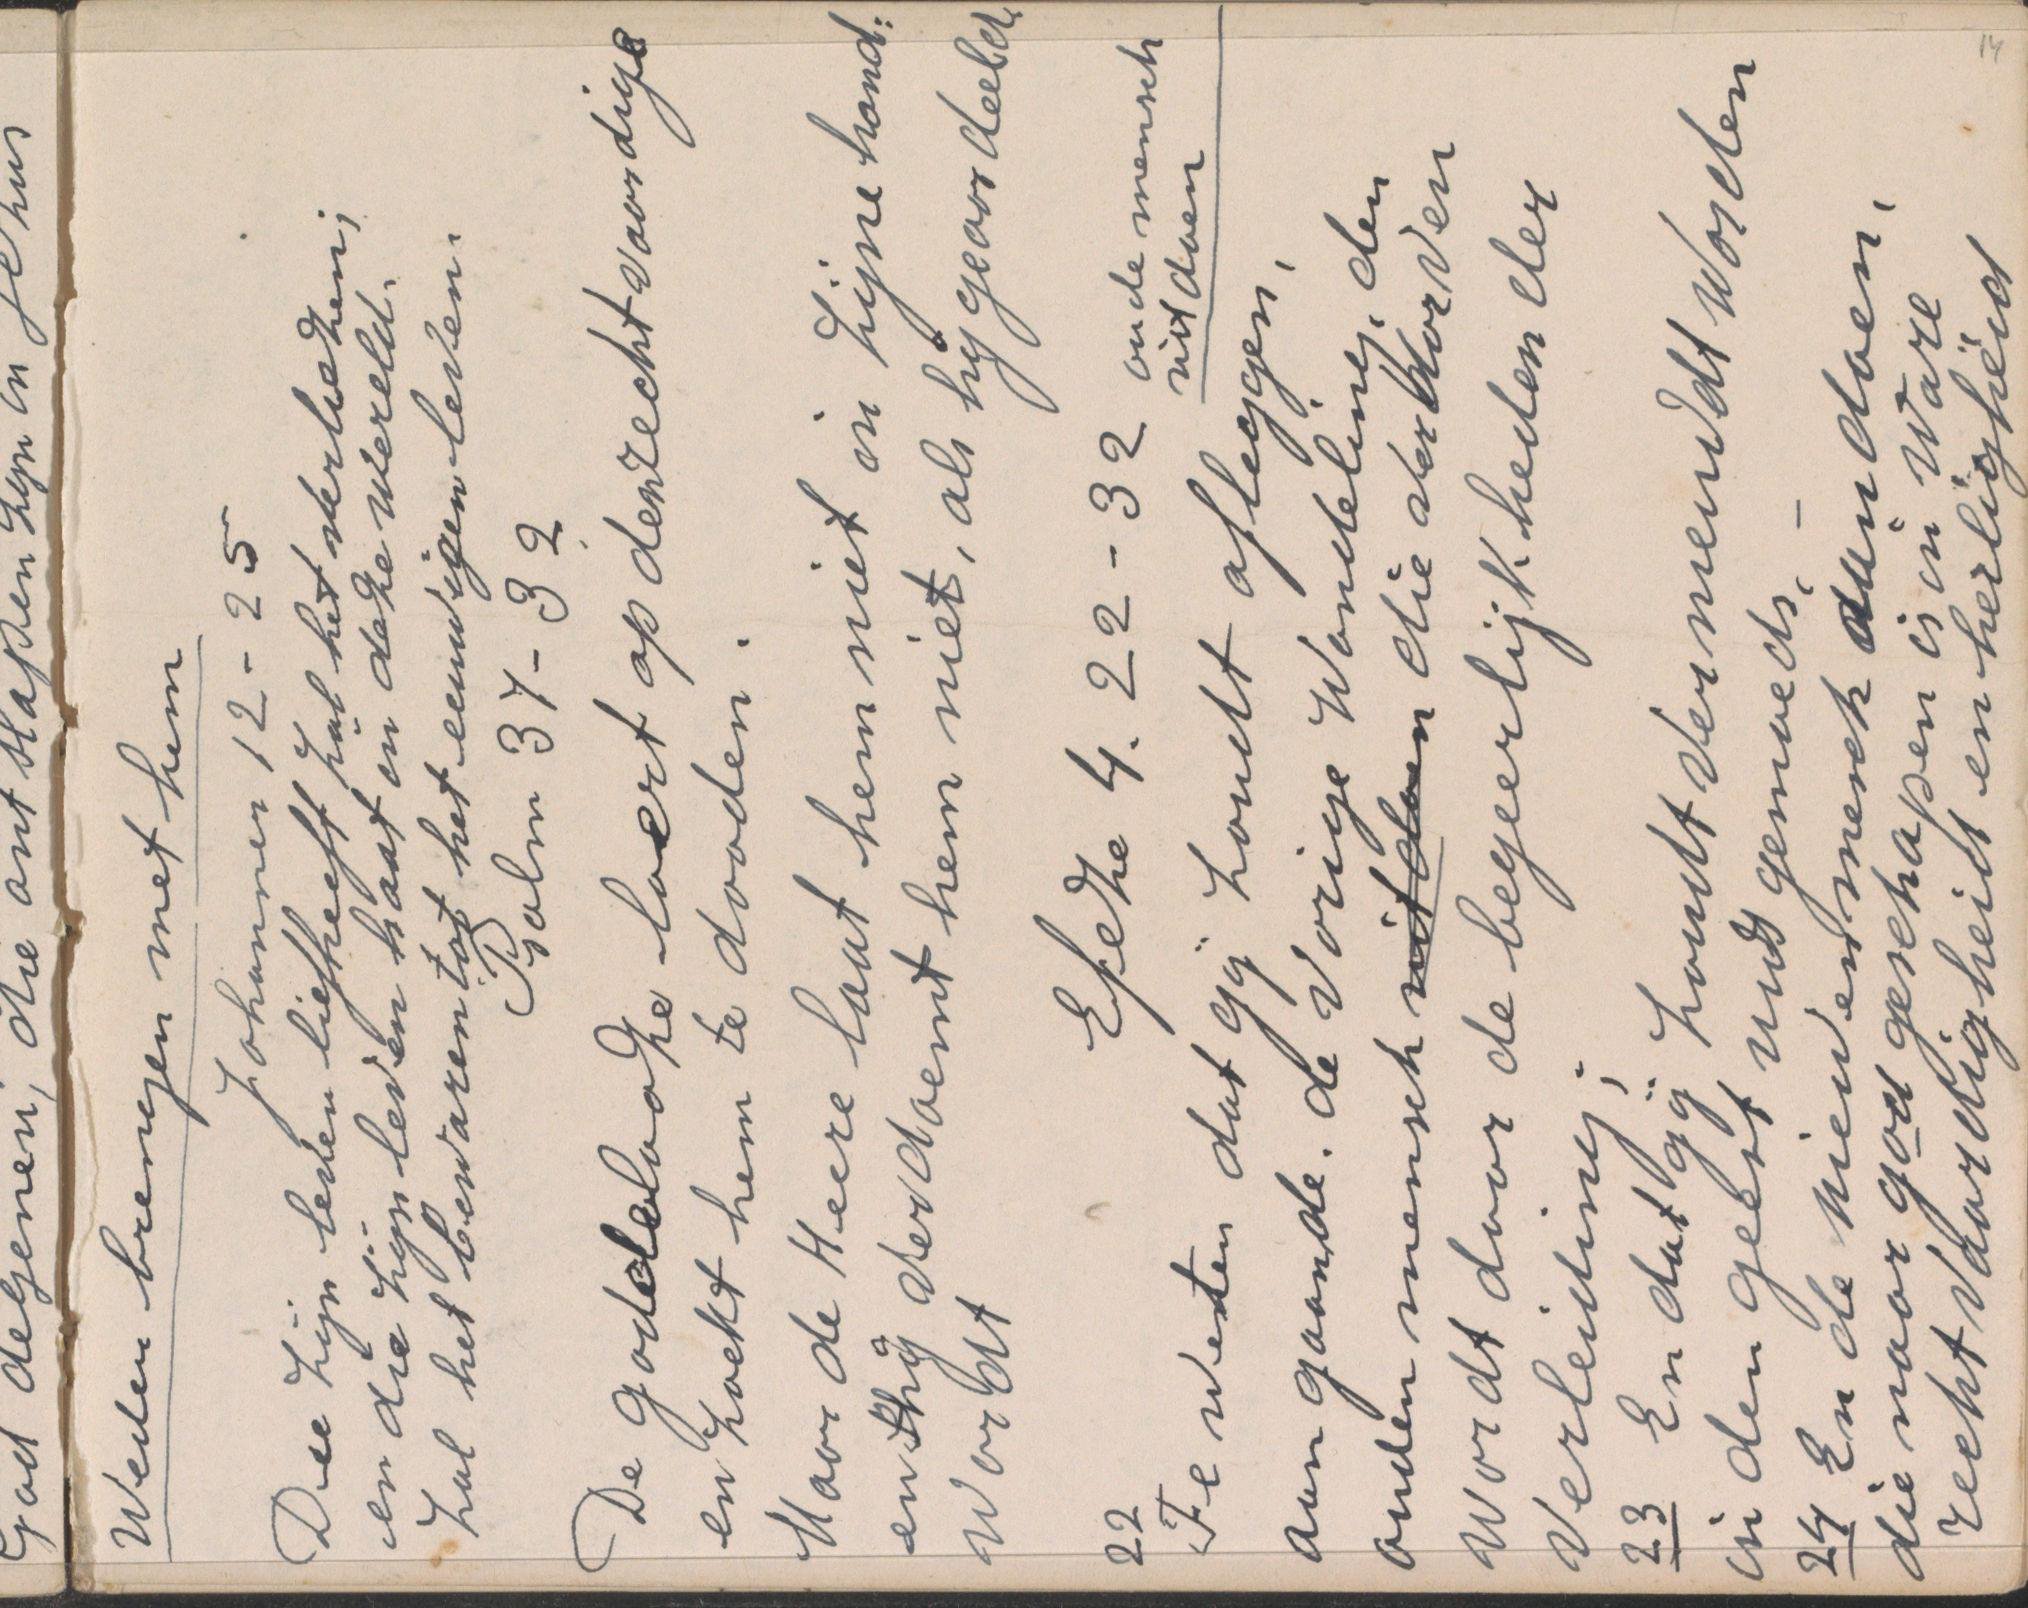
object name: sketchbook leaf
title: Bijbelverzen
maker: marie jordan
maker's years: 1866-1948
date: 1906-1948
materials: ink, paper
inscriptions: annotation: ‘[...]’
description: Pagina 14 uit een schetsboek met 31 bladen.